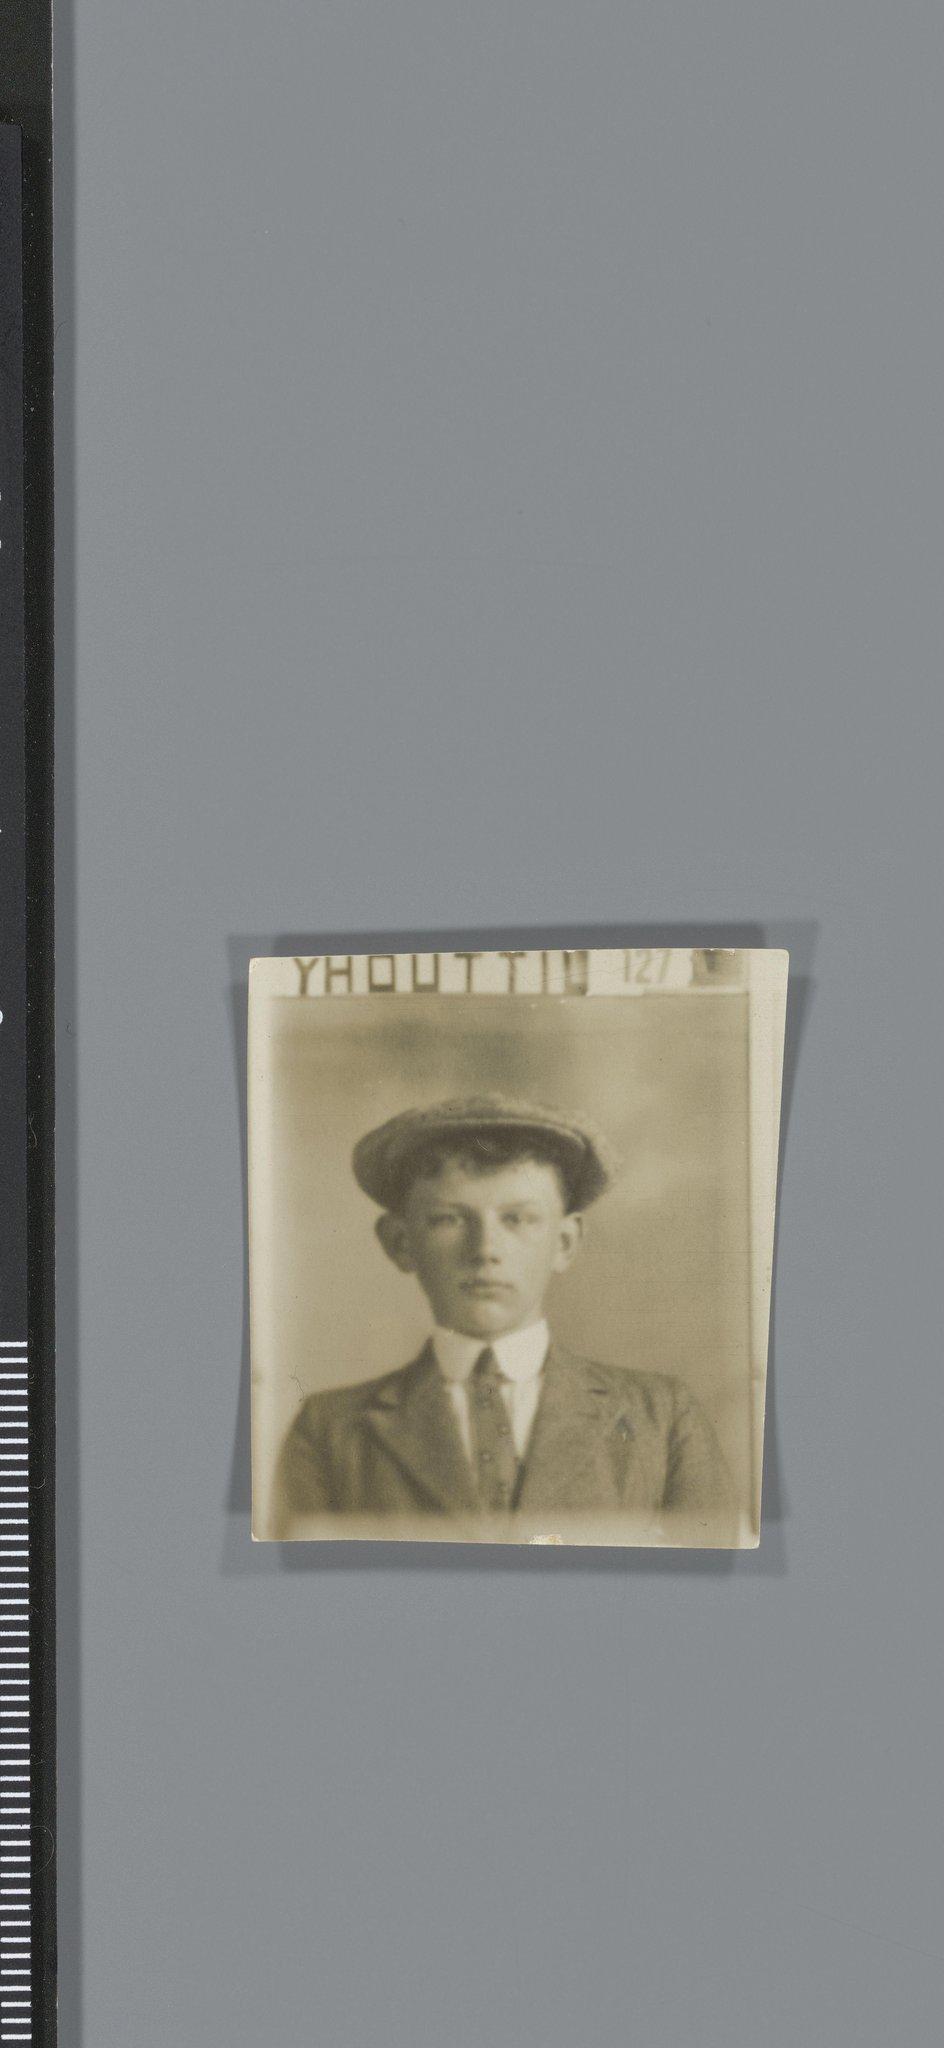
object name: snapshot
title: Rapid photographs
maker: jan gottfried stütner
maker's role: fotograaf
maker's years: 1892-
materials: photographic support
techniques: gelatin silver print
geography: alkmaar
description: Between 1912 and 1930, anyone could have their portrait taken at the many so-called rapid photography studios in the shopping streets of mainly (medium) large-size European cities. As if on an assembly line, the youngest clerk shot the photographs with a special camera and in artificial light and developed them. Later in the day, the customer collected a sheet with 12 portrait photos for 25 cents. This form of photographic mass production gave rise to a fascinating tableau of boys, girls, men and women not previously seen in photographs; candid and informal. There were at least 150 quick-photo studios, from Alkmaar to Zutphen. Many called themselves ‘American,’ mistakenly as it turns out because hardly any examples from that country have been found.